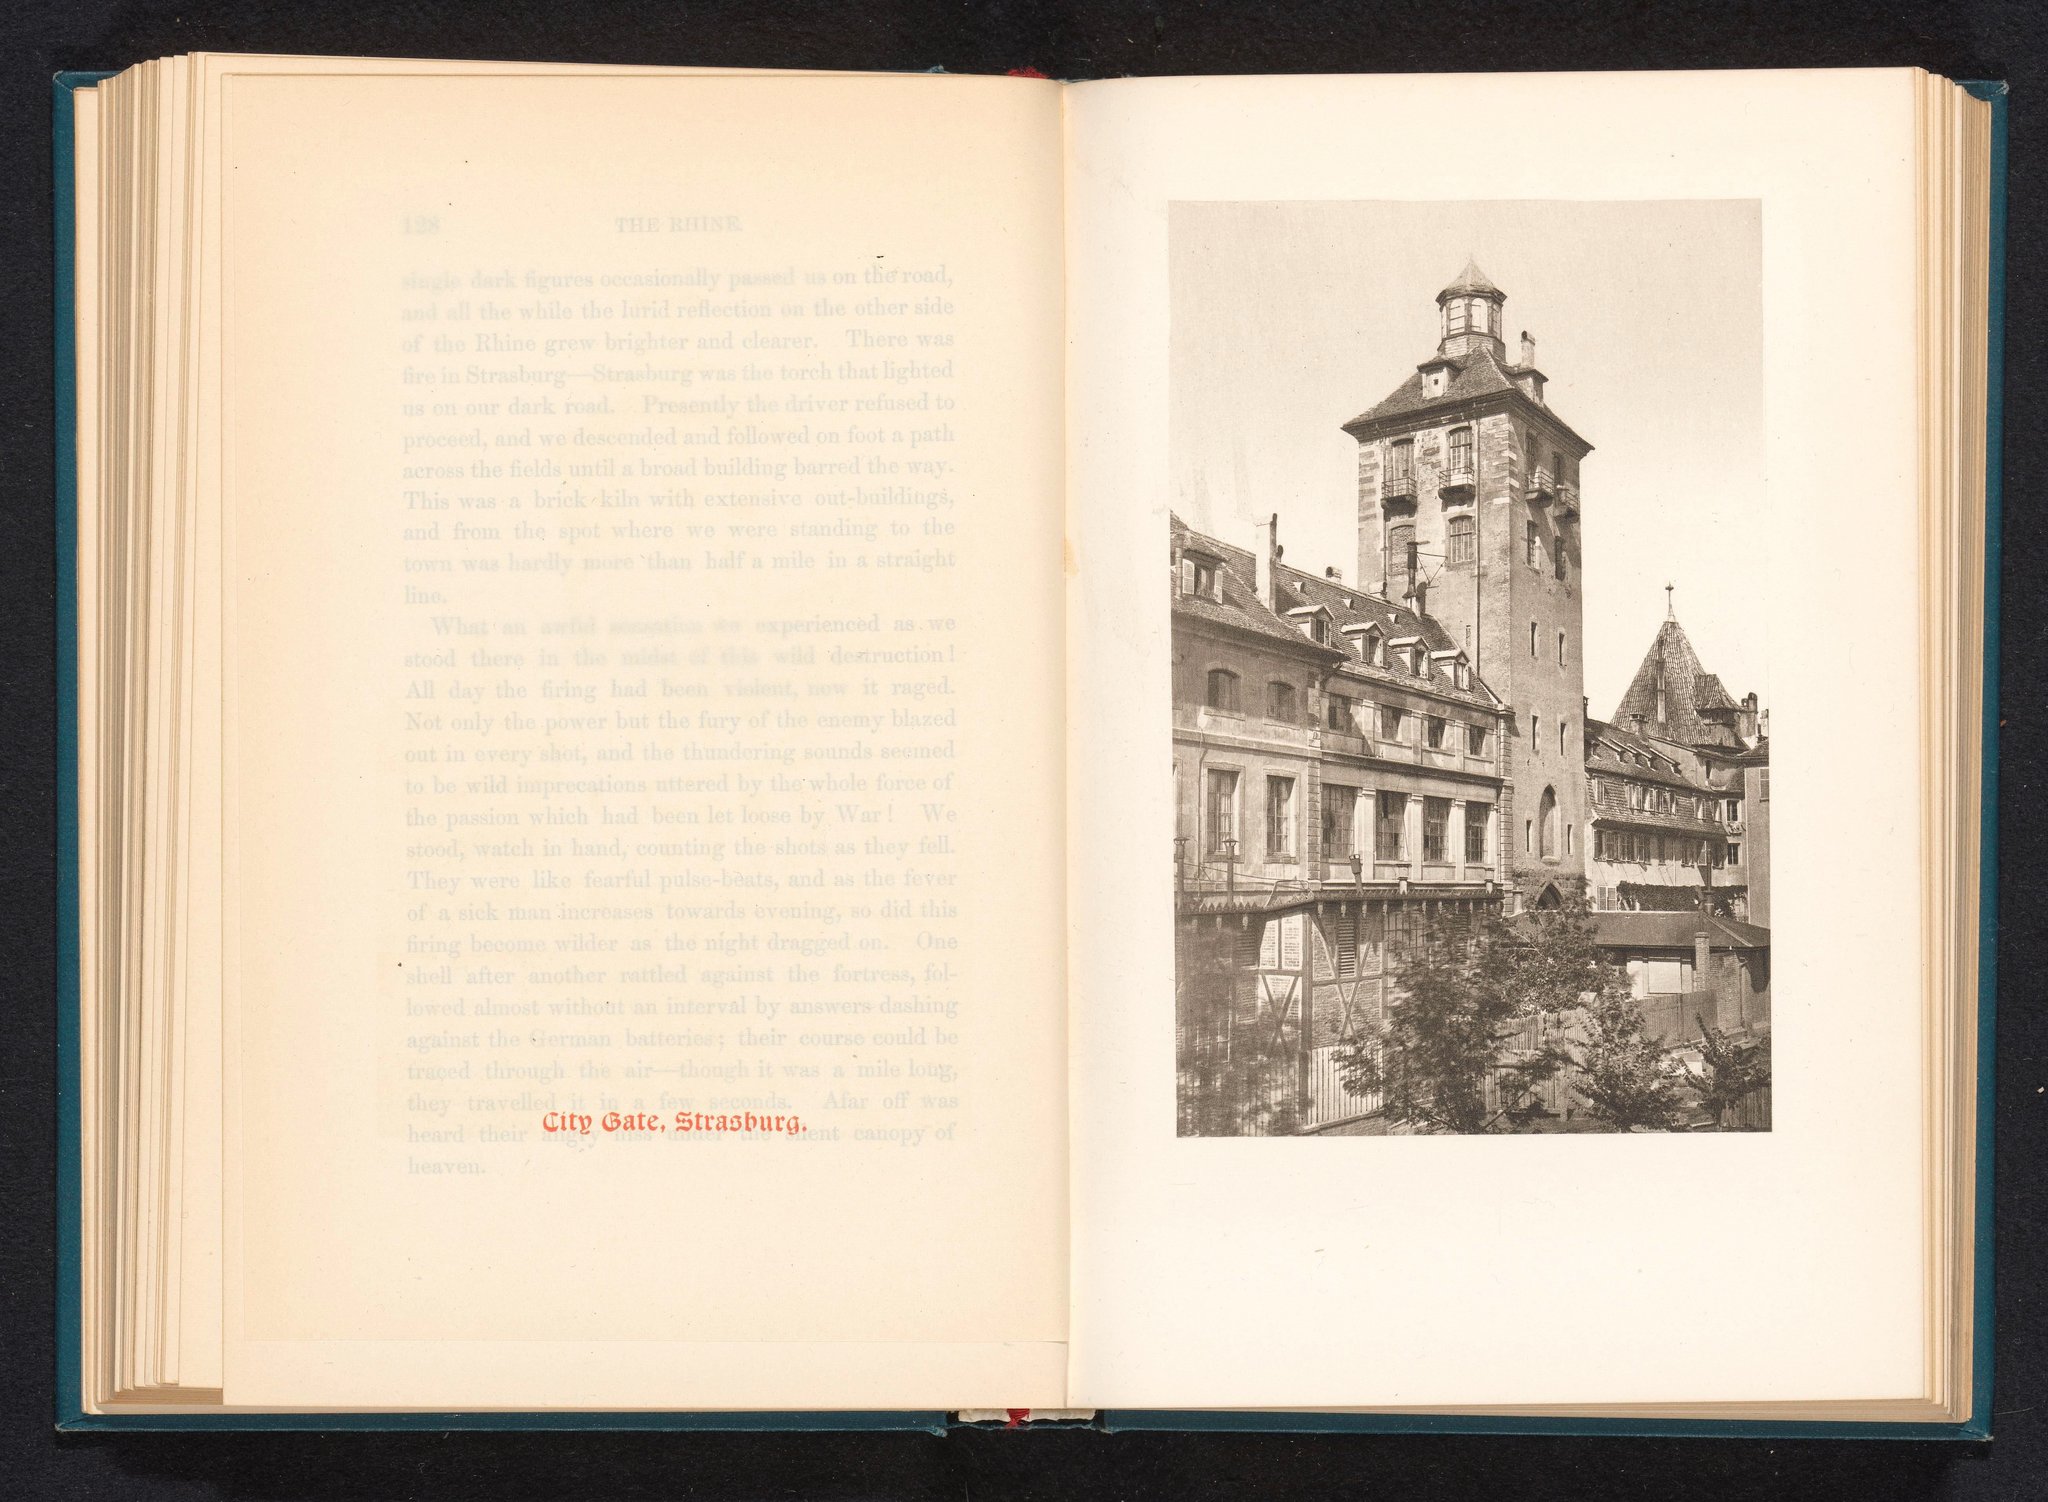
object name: page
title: Gezicht op de Porte de l'Hôpital te Straatsburg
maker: Anonymous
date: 1889-1899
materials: paper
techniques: photoaquatint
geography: straatsburg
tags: tower, clock tower ~ monumental adornment, city-gate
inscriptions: title: ‘City Gate, Strasburg.’